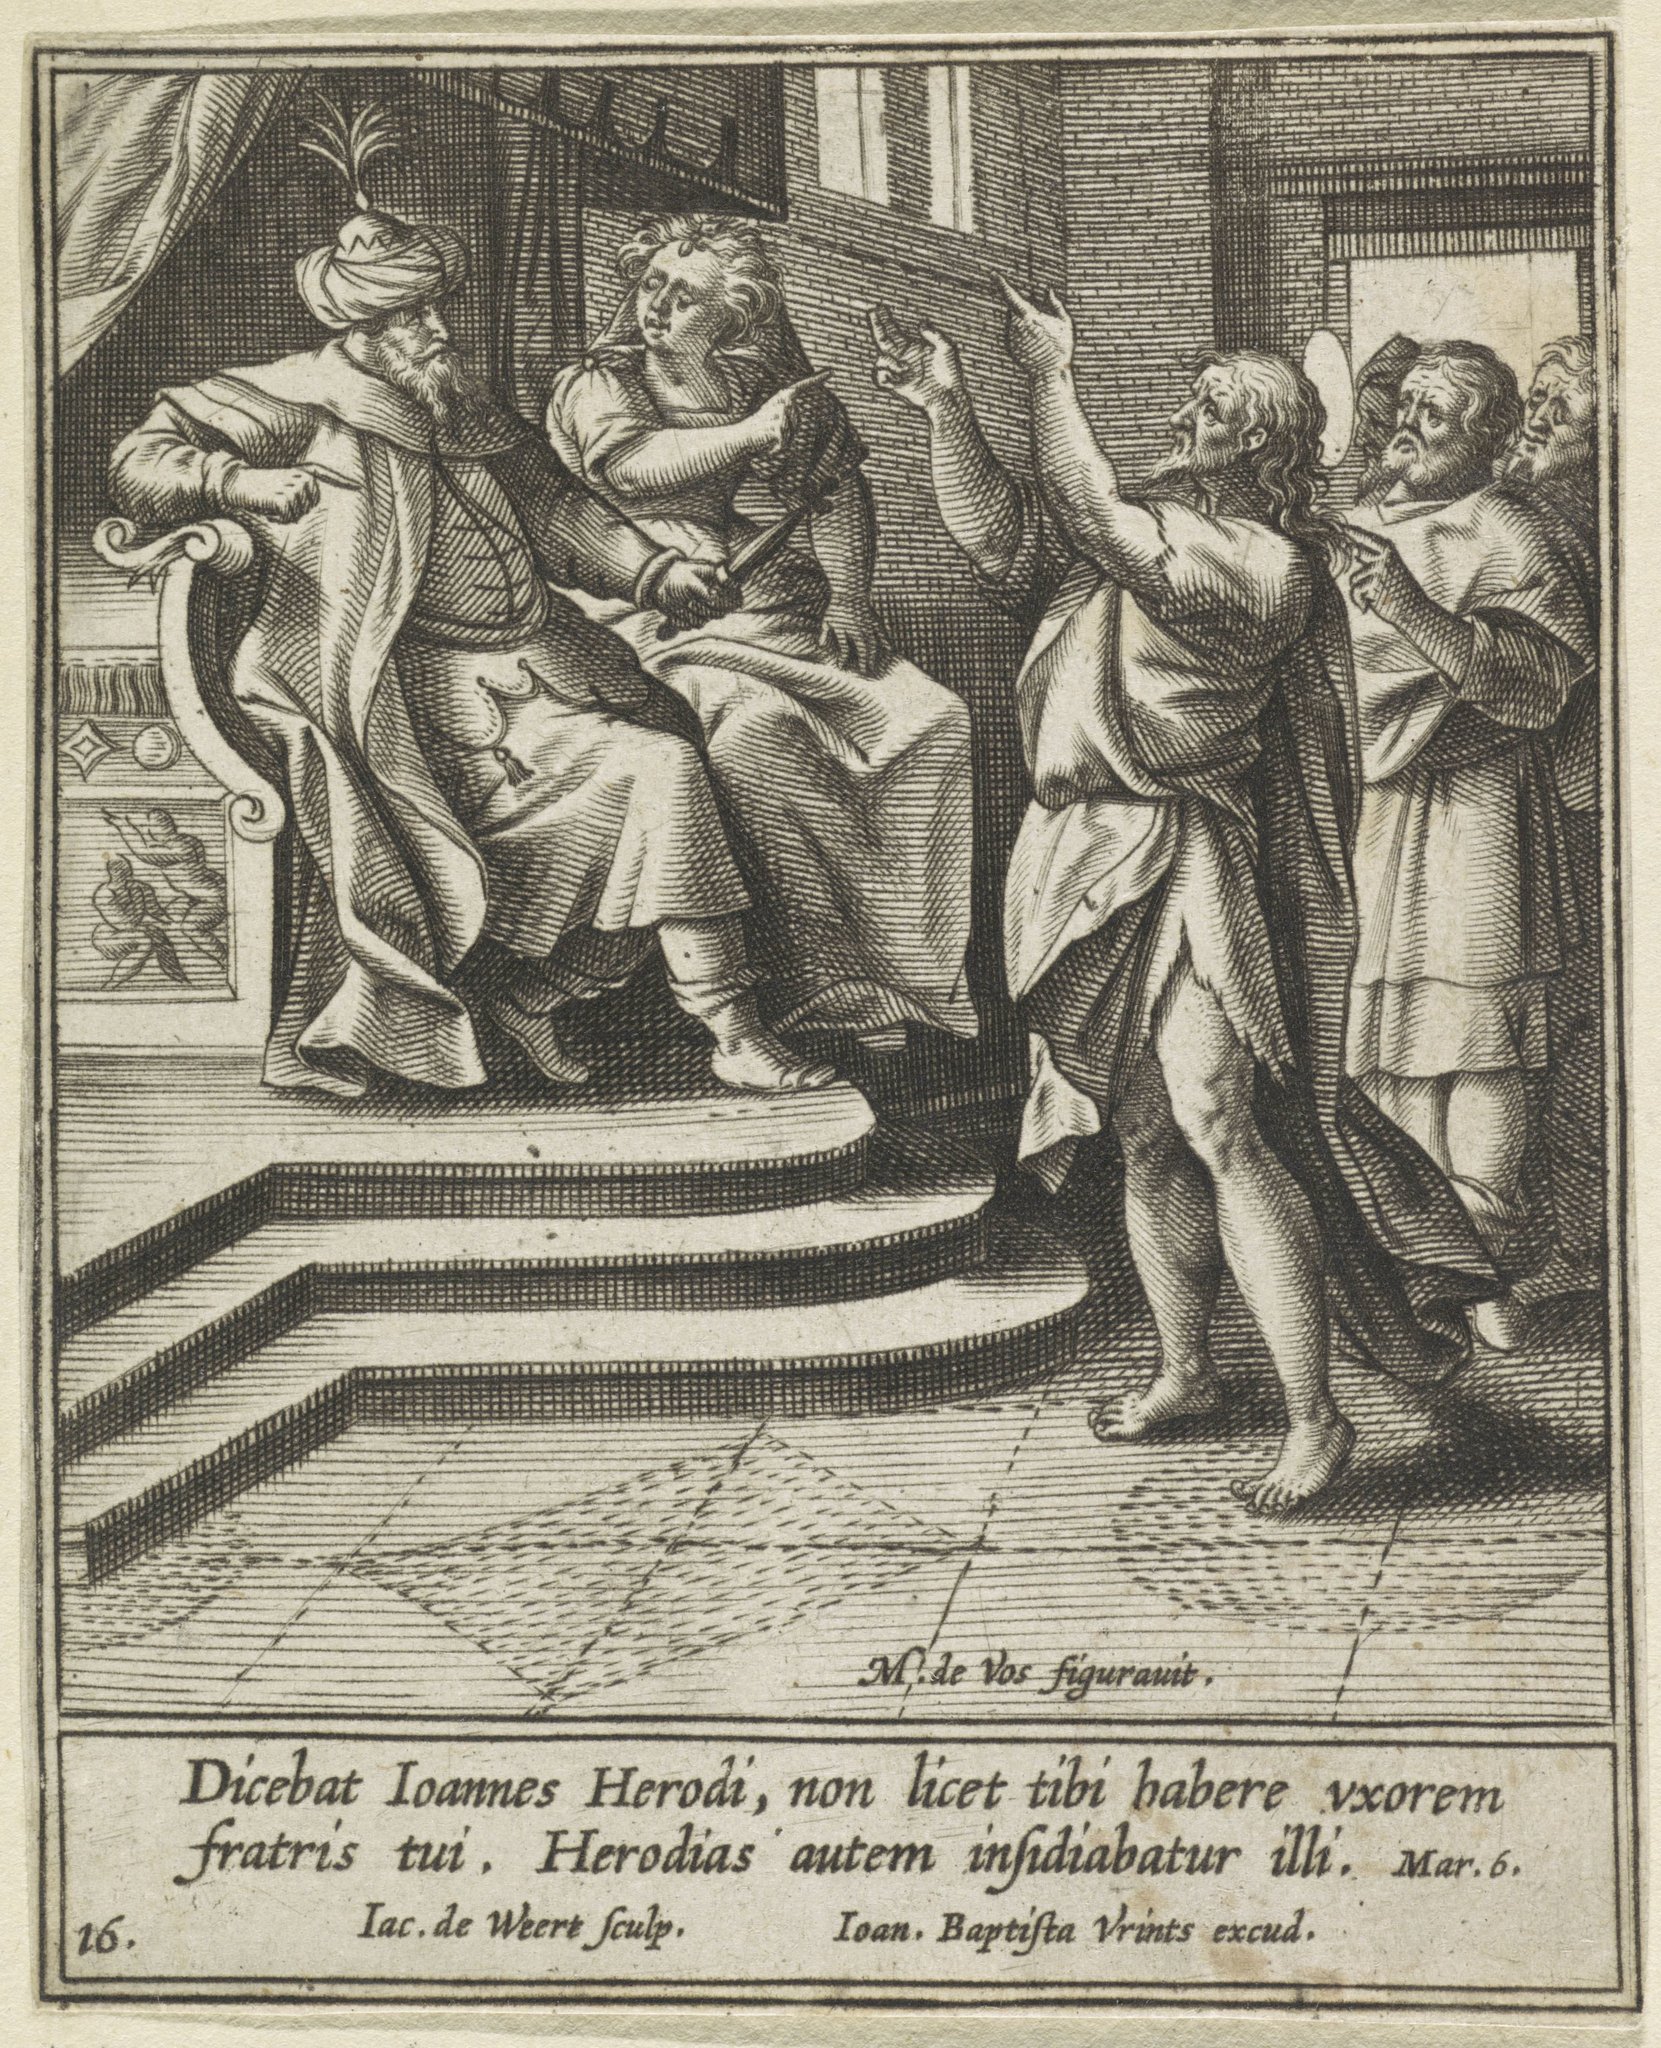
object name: print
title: Johannes de Doper wijst Herodes en Herodias terecht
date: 1580-1600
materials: paper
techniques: engraving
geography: antwerp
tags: john the baptist reproaches herod (herod antipas) and herodias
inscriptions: collector's mark: Lugt 240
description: Johannes de Doper staat met opgeheven armen voor Herodes en Herodias. Achter hem zijn nog enkele figuren te zien. Onder de voorstelling bevindt zich een tweeregelige, Latijnse tekst met de beschrijving van de scène uit Marc. 6